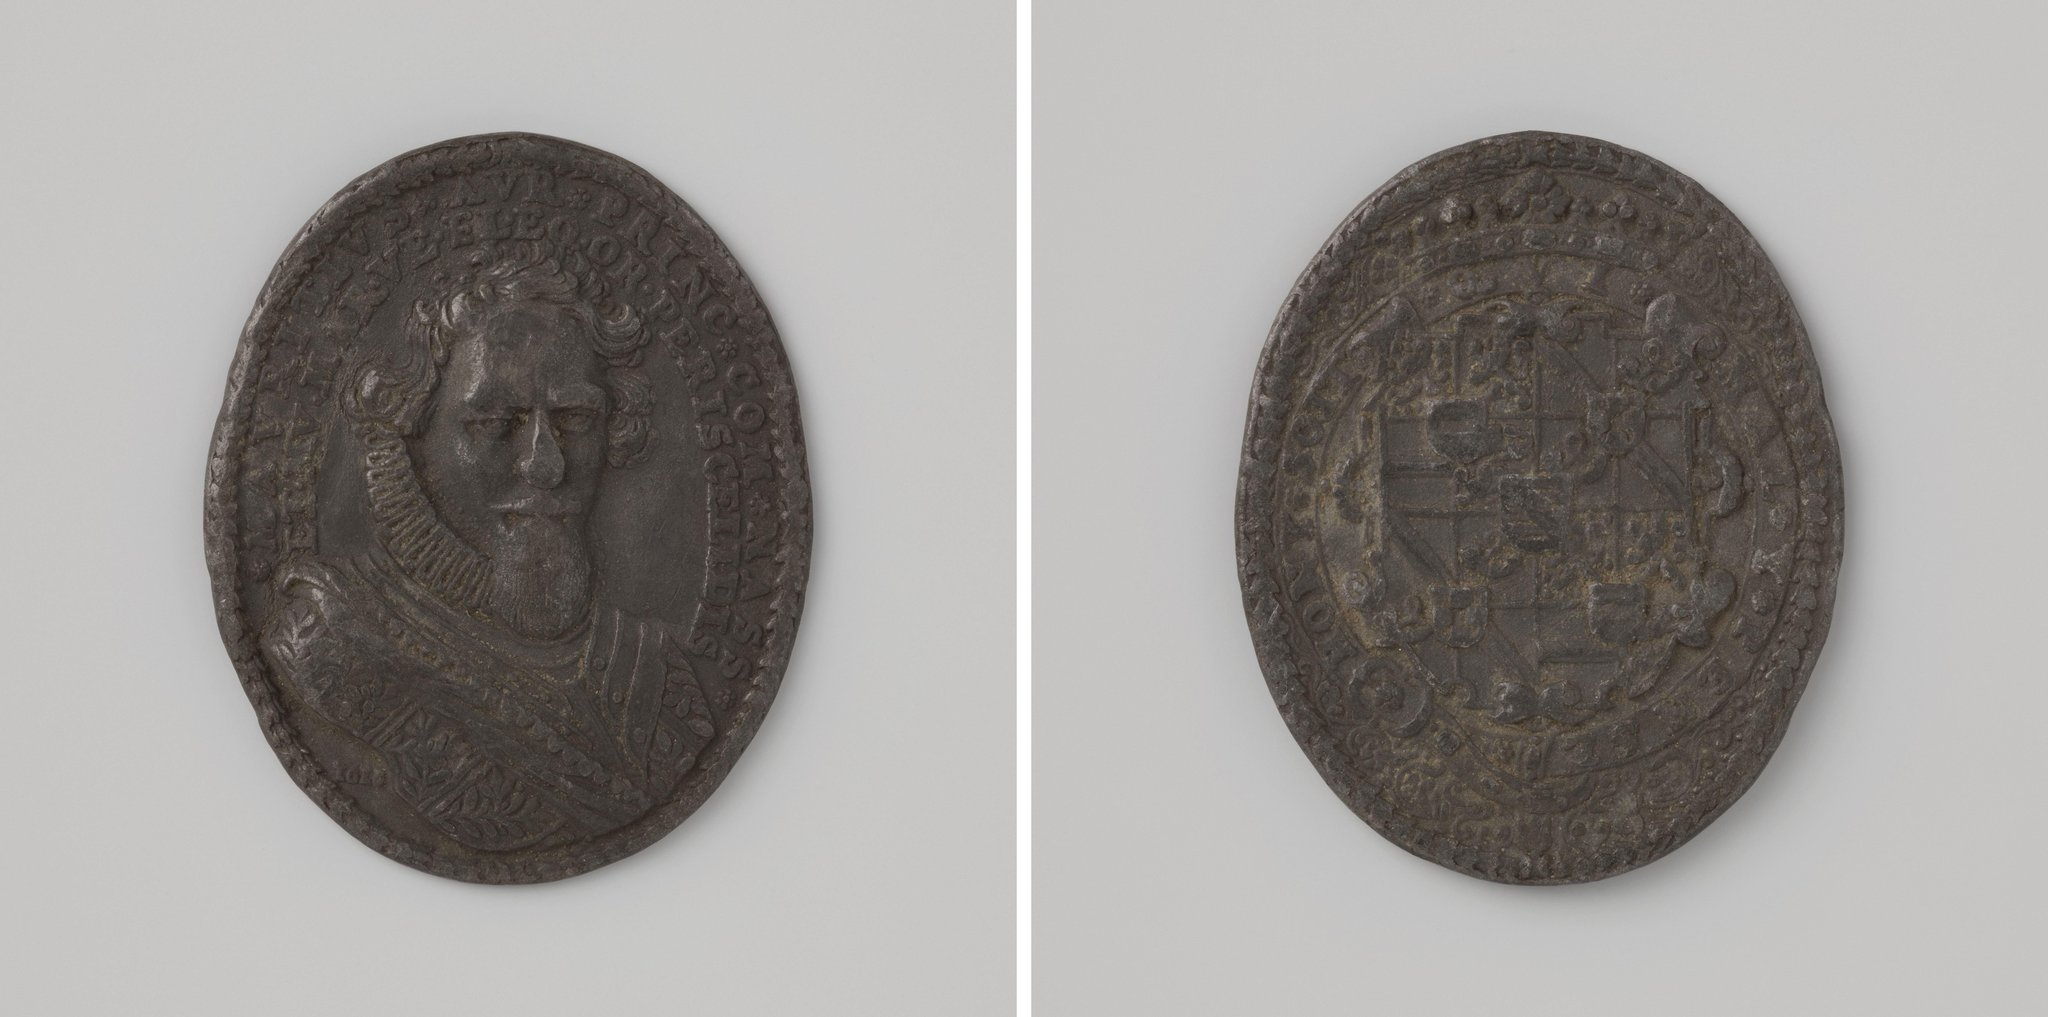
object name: history medal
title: Prins Maurits Ridder in de Orde van de Kouseband 1613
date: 1613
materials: tin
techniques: casting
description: Ovale tinnen penning, op de voorzijde het borstbeeld van Prins Maurits, het hoofd aanziend, met dubbel omschrift, op de keerzijde een gekroond versierd wapenschild omhangen met de kousenband.